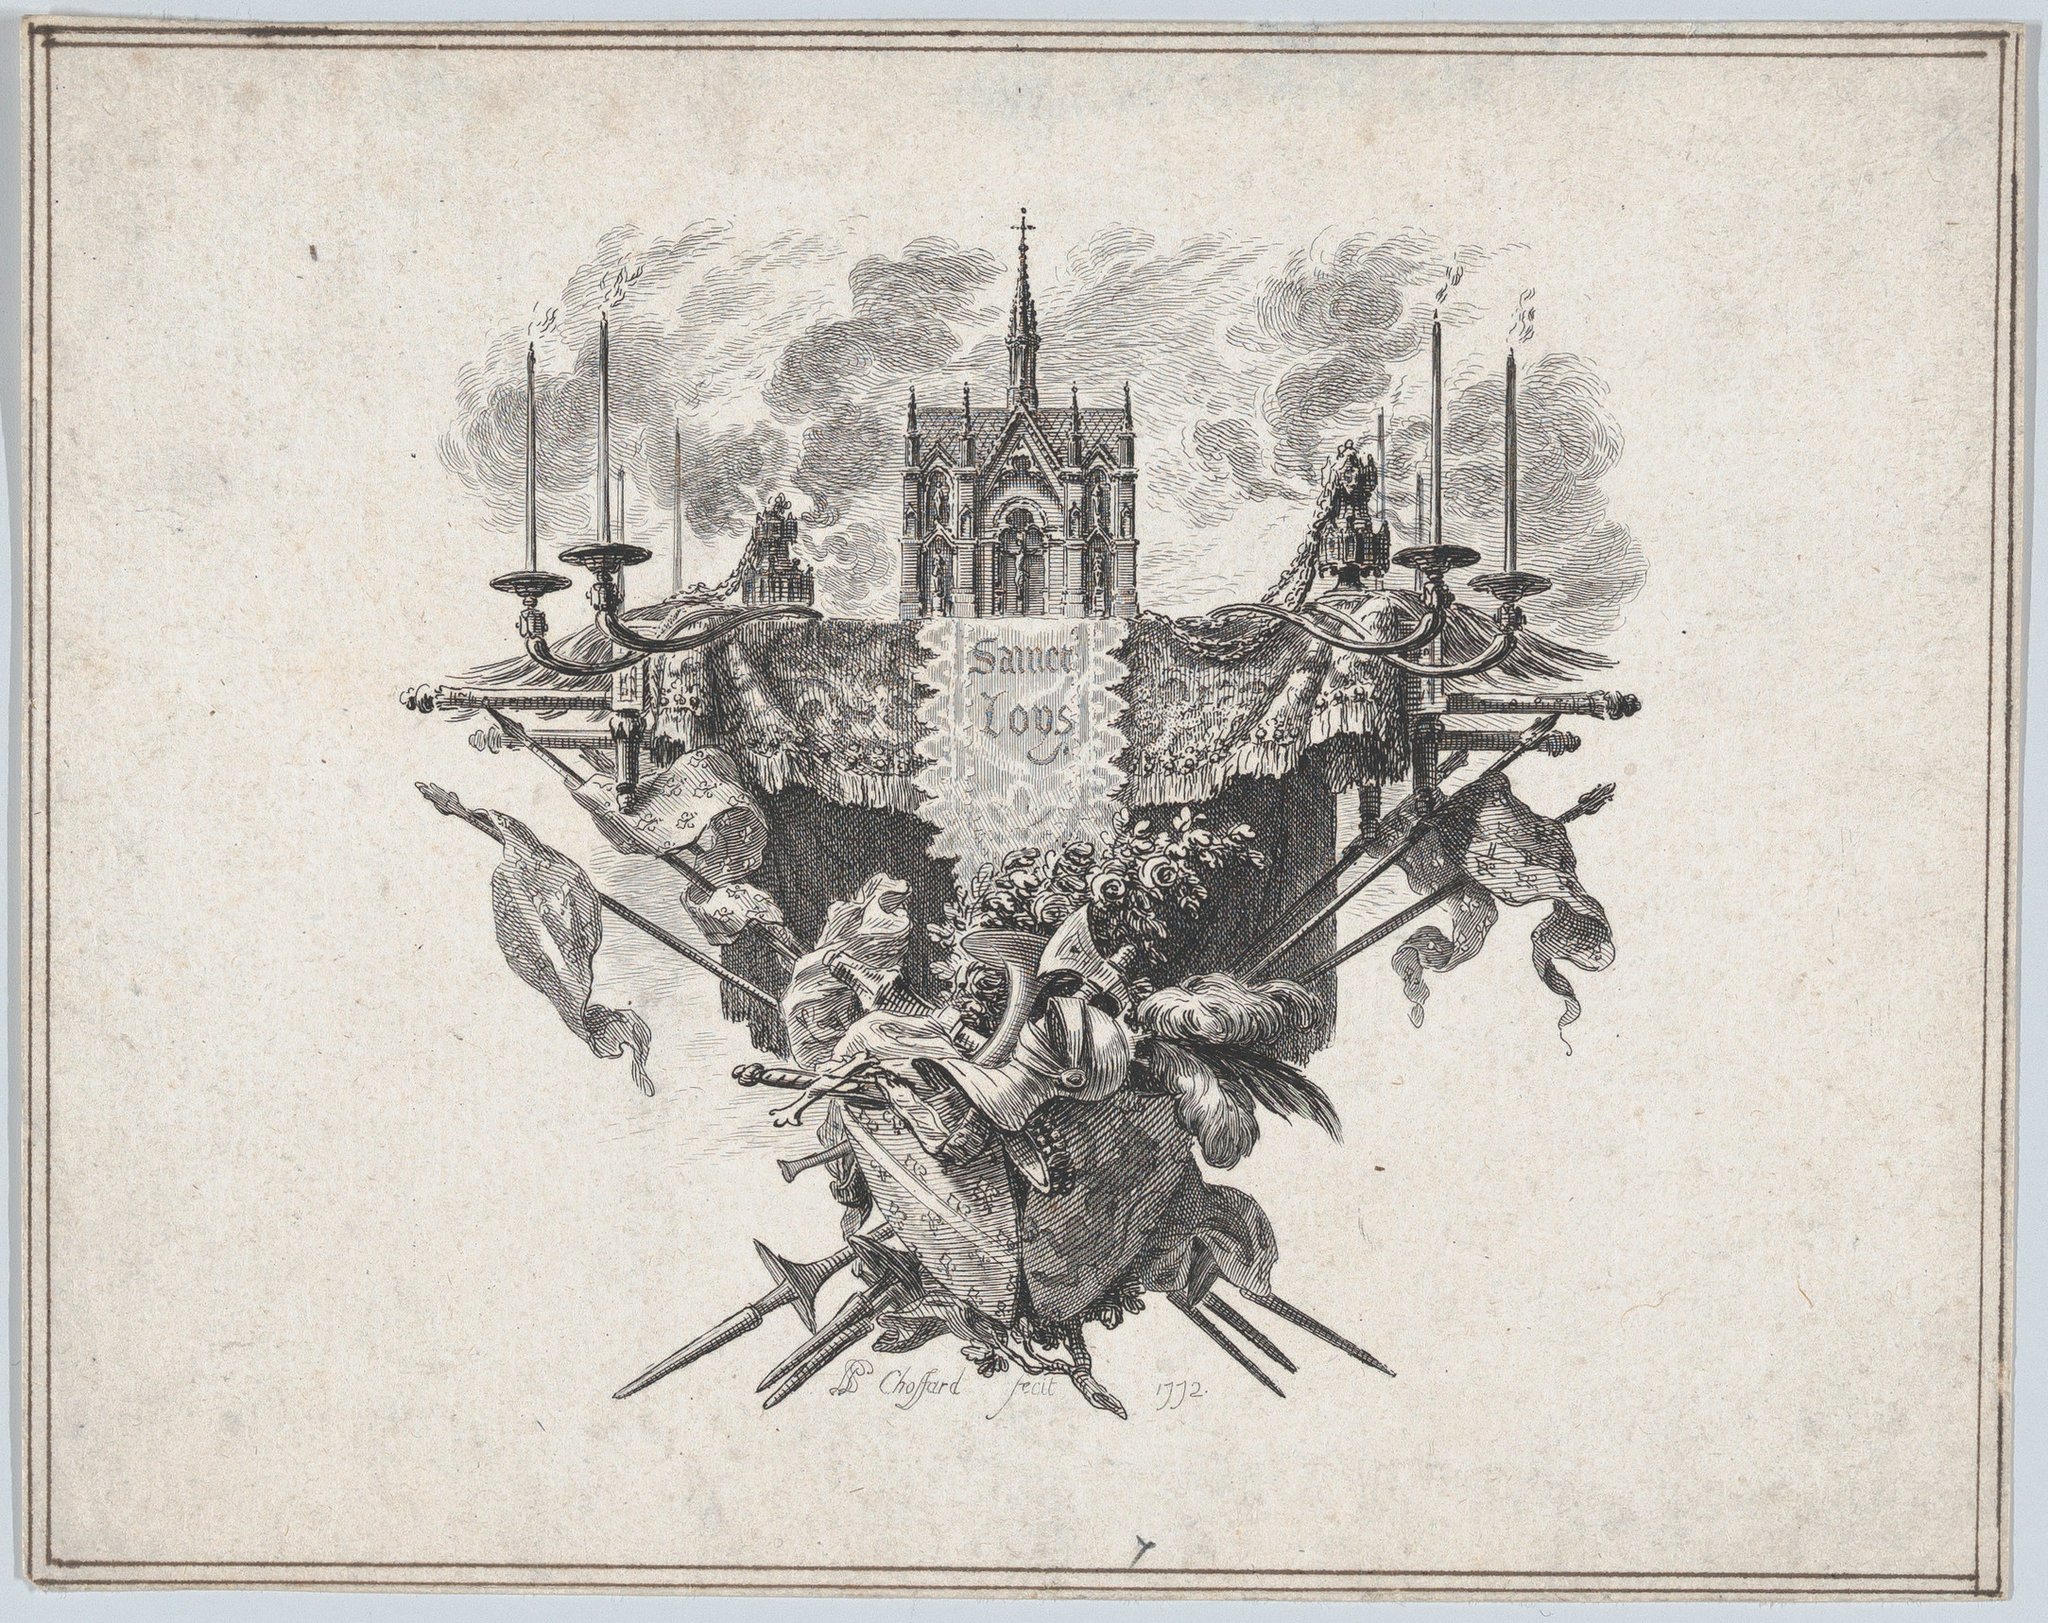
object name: print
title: Saint Louis Vignette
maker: pierre philippe choffard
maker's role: artist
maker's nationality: french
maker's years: 1730-1809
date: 1772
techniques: engraving, etching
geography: paris